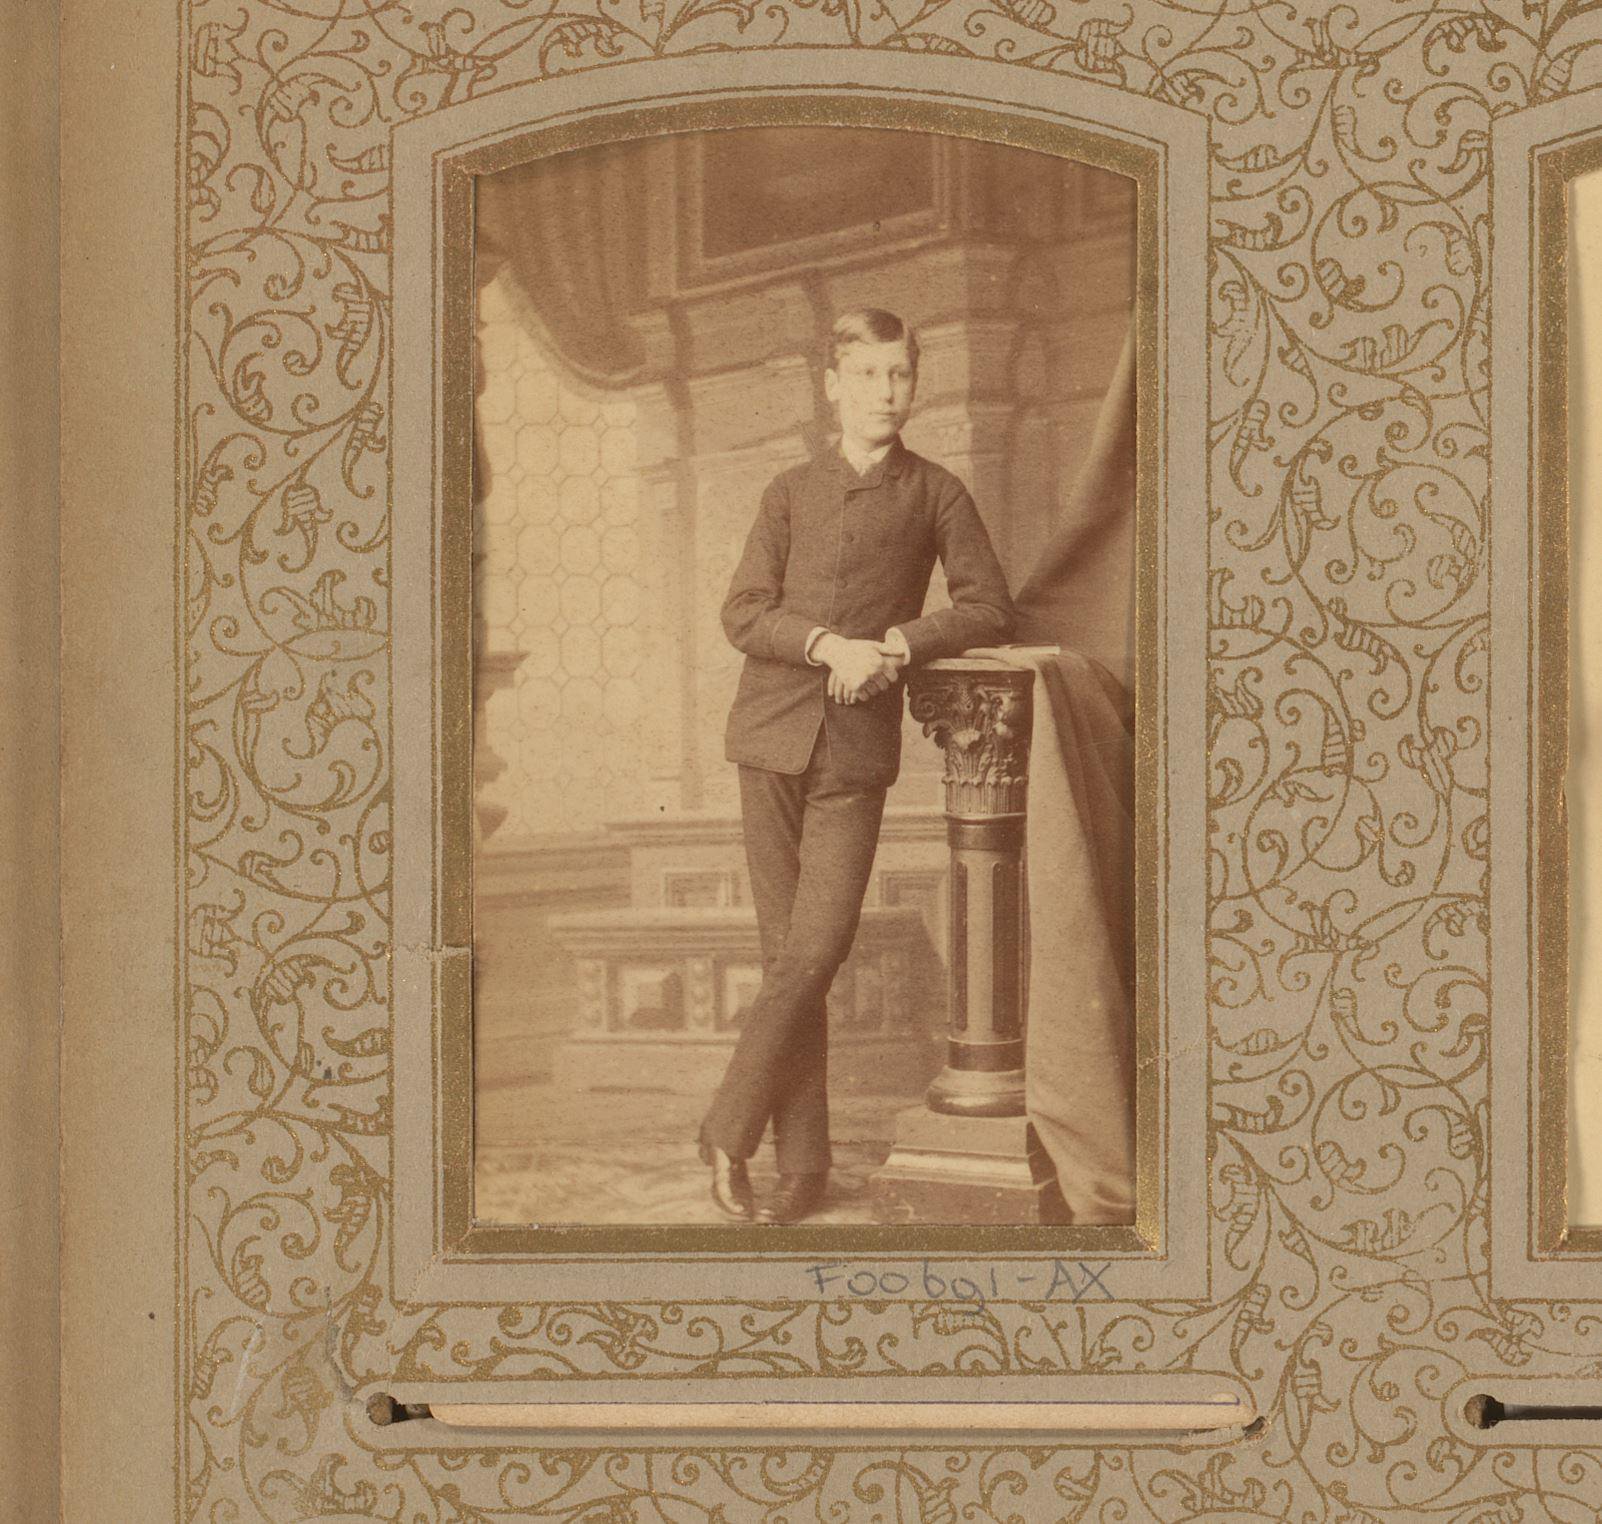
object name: carte de visite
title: Portret van een jongeman bij een zuil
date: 1875-1899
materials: cardboard, photographic support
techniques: albumen print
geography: amsterdam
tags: adolescent, young woman, maiden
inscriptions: inscription: ‘Photographie Française/ Warmoesstraat 147/ Amsterdam’